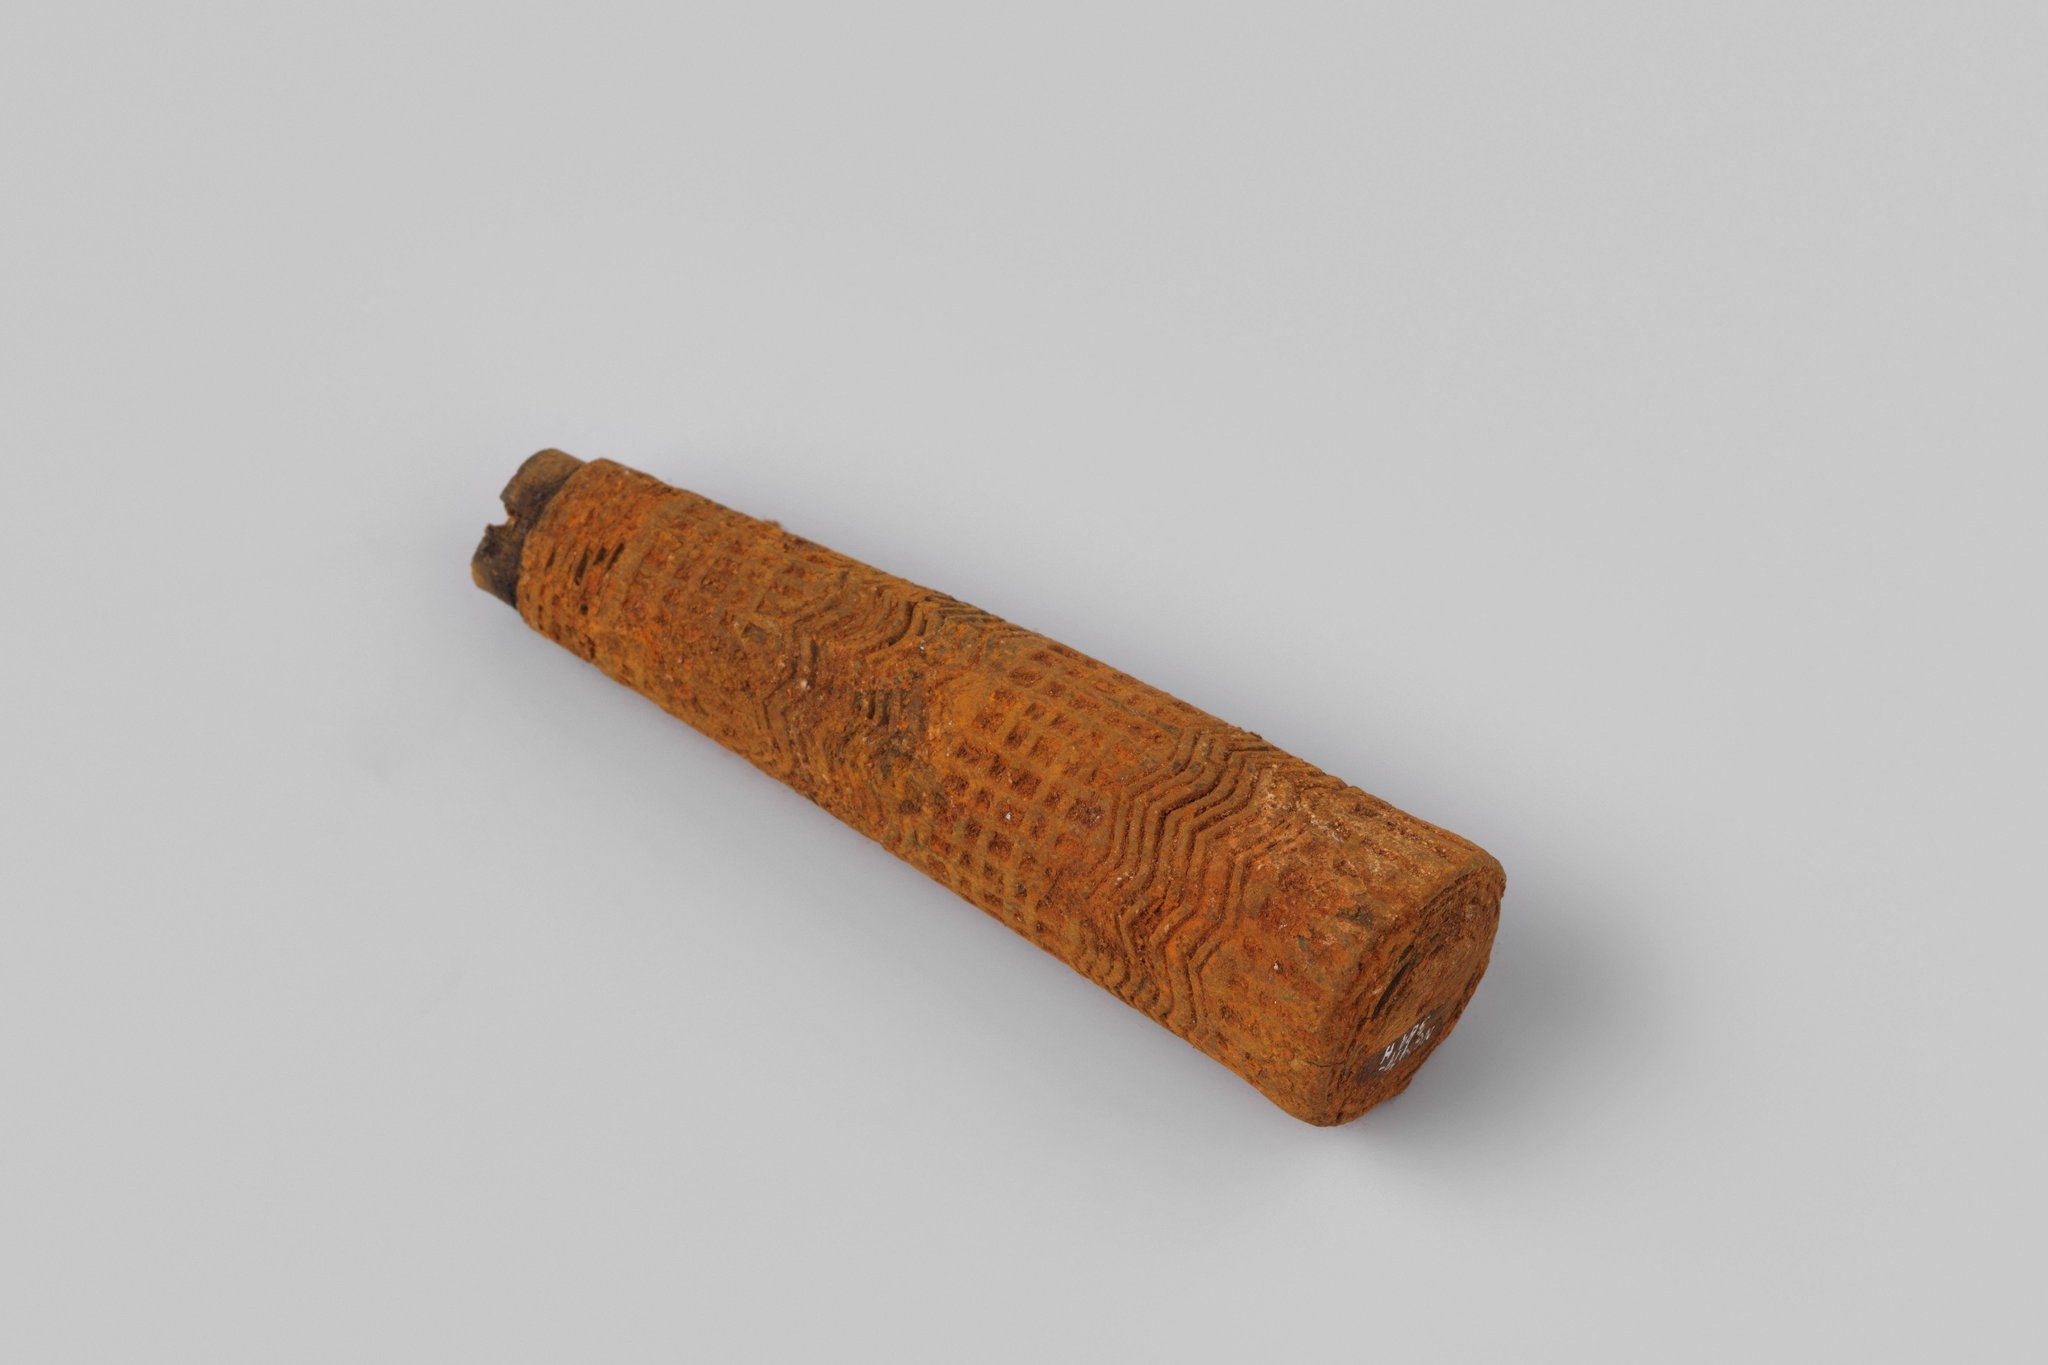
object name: knife handle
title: Messenheft uit het wrak van de Oost-Indiëvaarder Hollandia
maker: Anonymous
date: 1700-1743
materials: wood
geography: netherlands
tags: verenigde oostindische compagnie, hollandia (schip), annet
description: Knife, handle, cylindrical: tapering; id. NG 1979-403H, ferrules id. NG 1980-27H426.